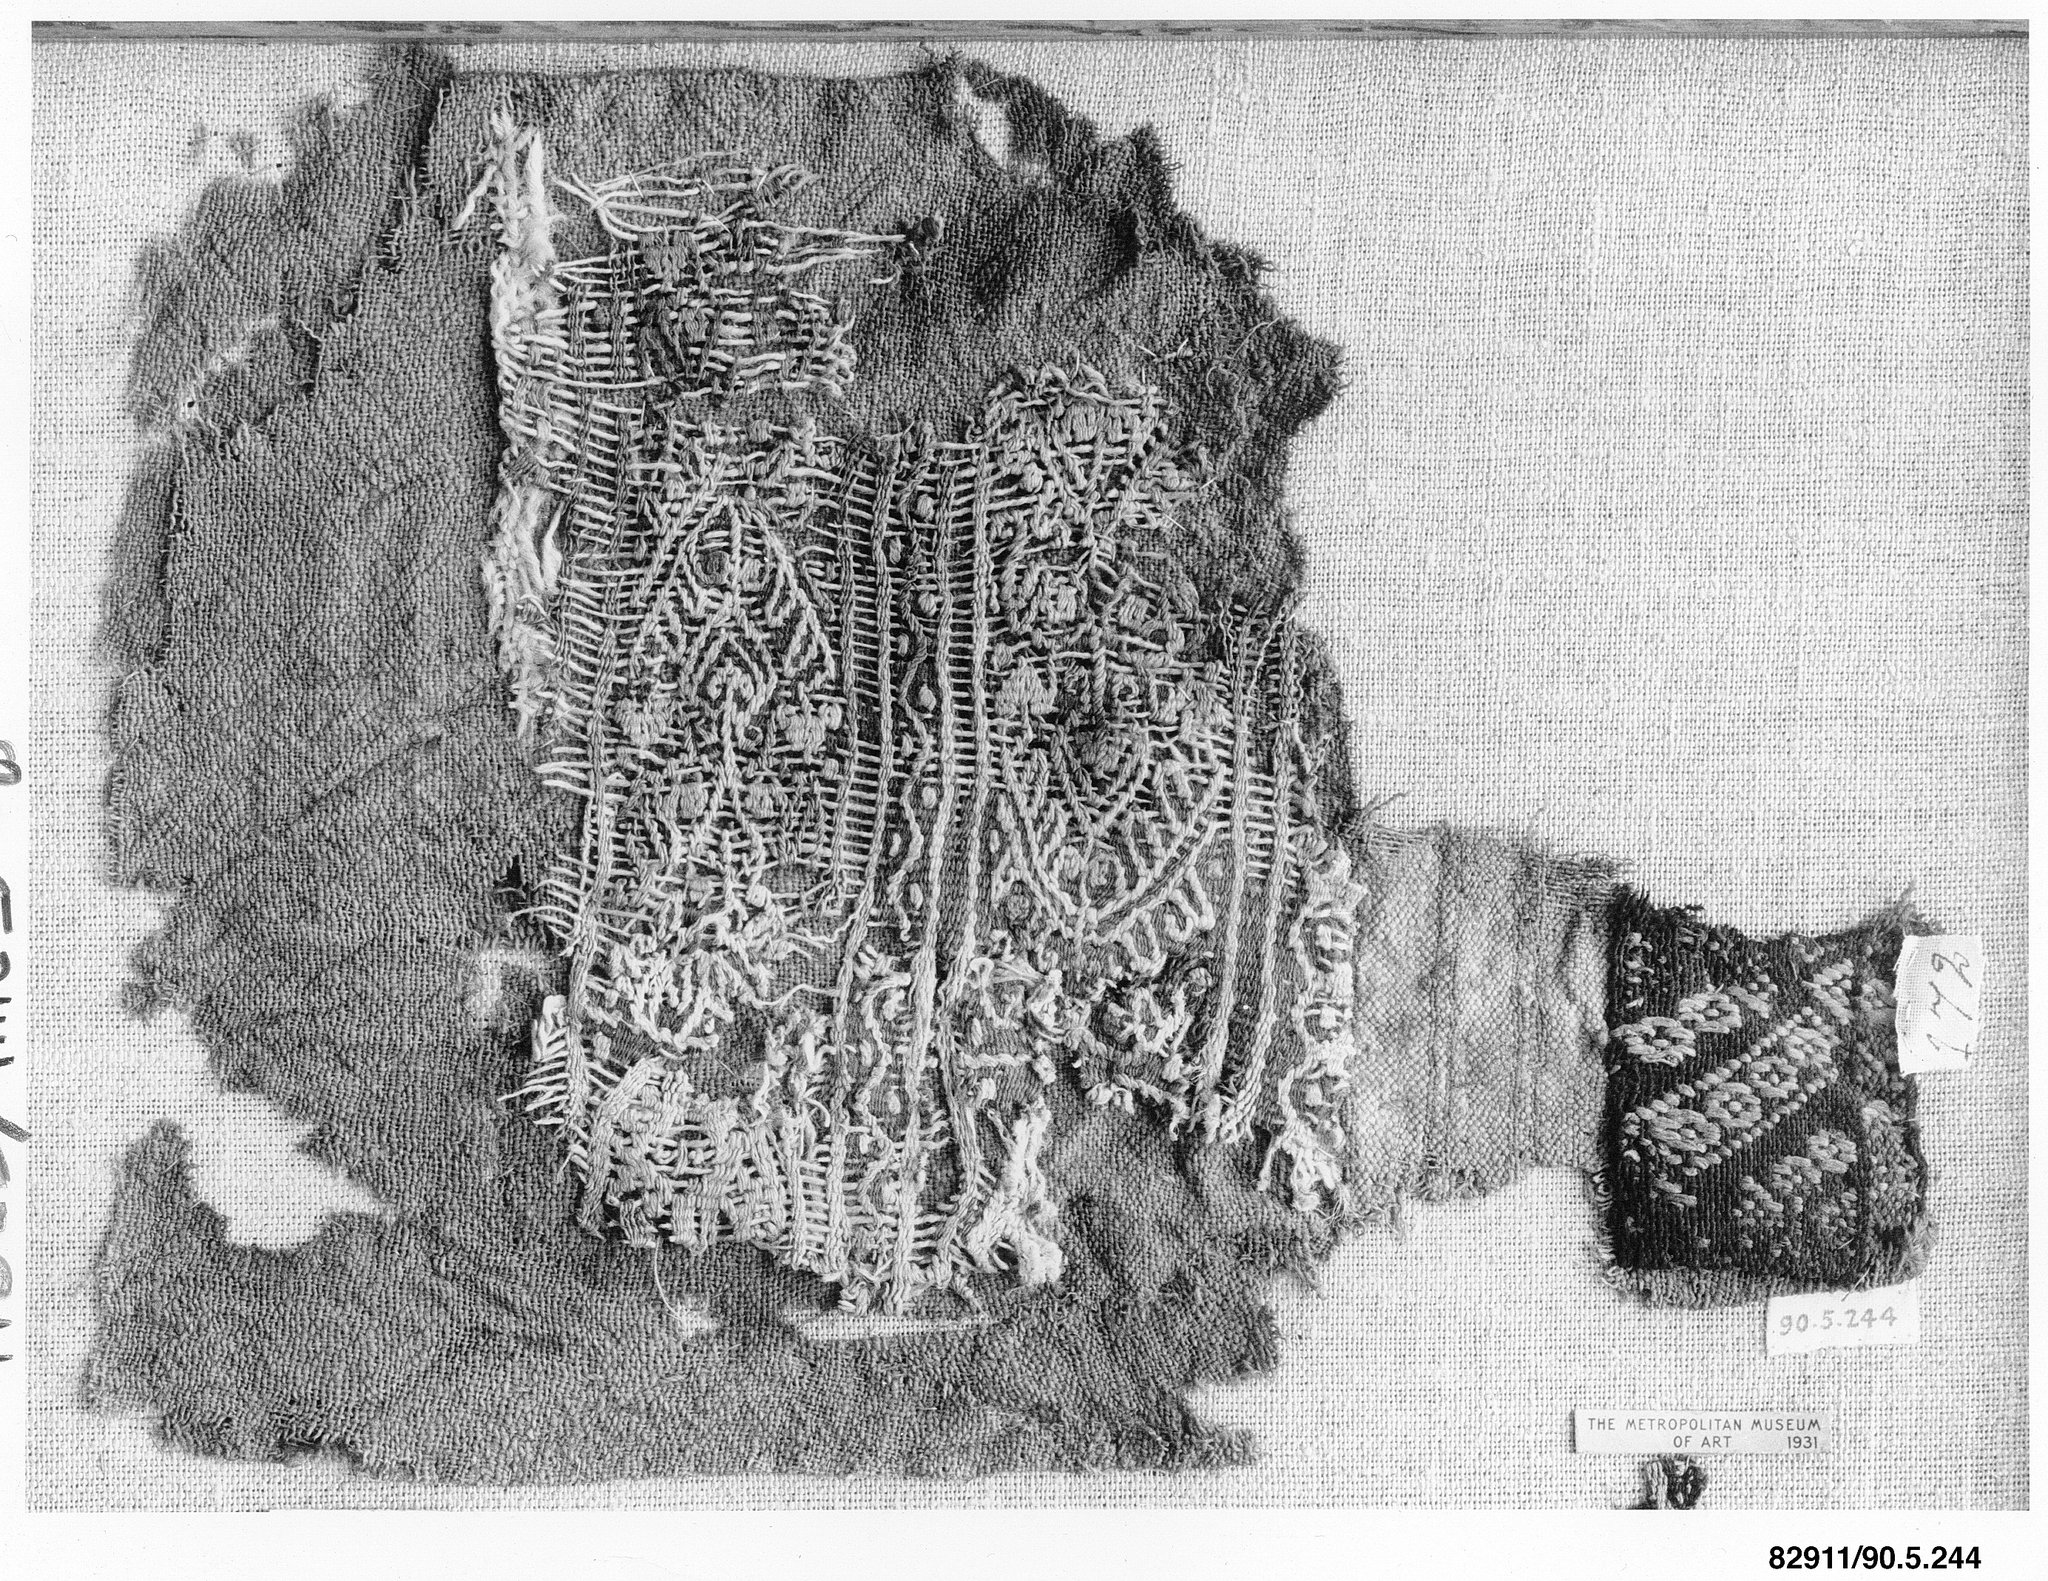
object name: textile fragment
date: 401-600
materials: linen, wool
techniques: weave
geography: egypt